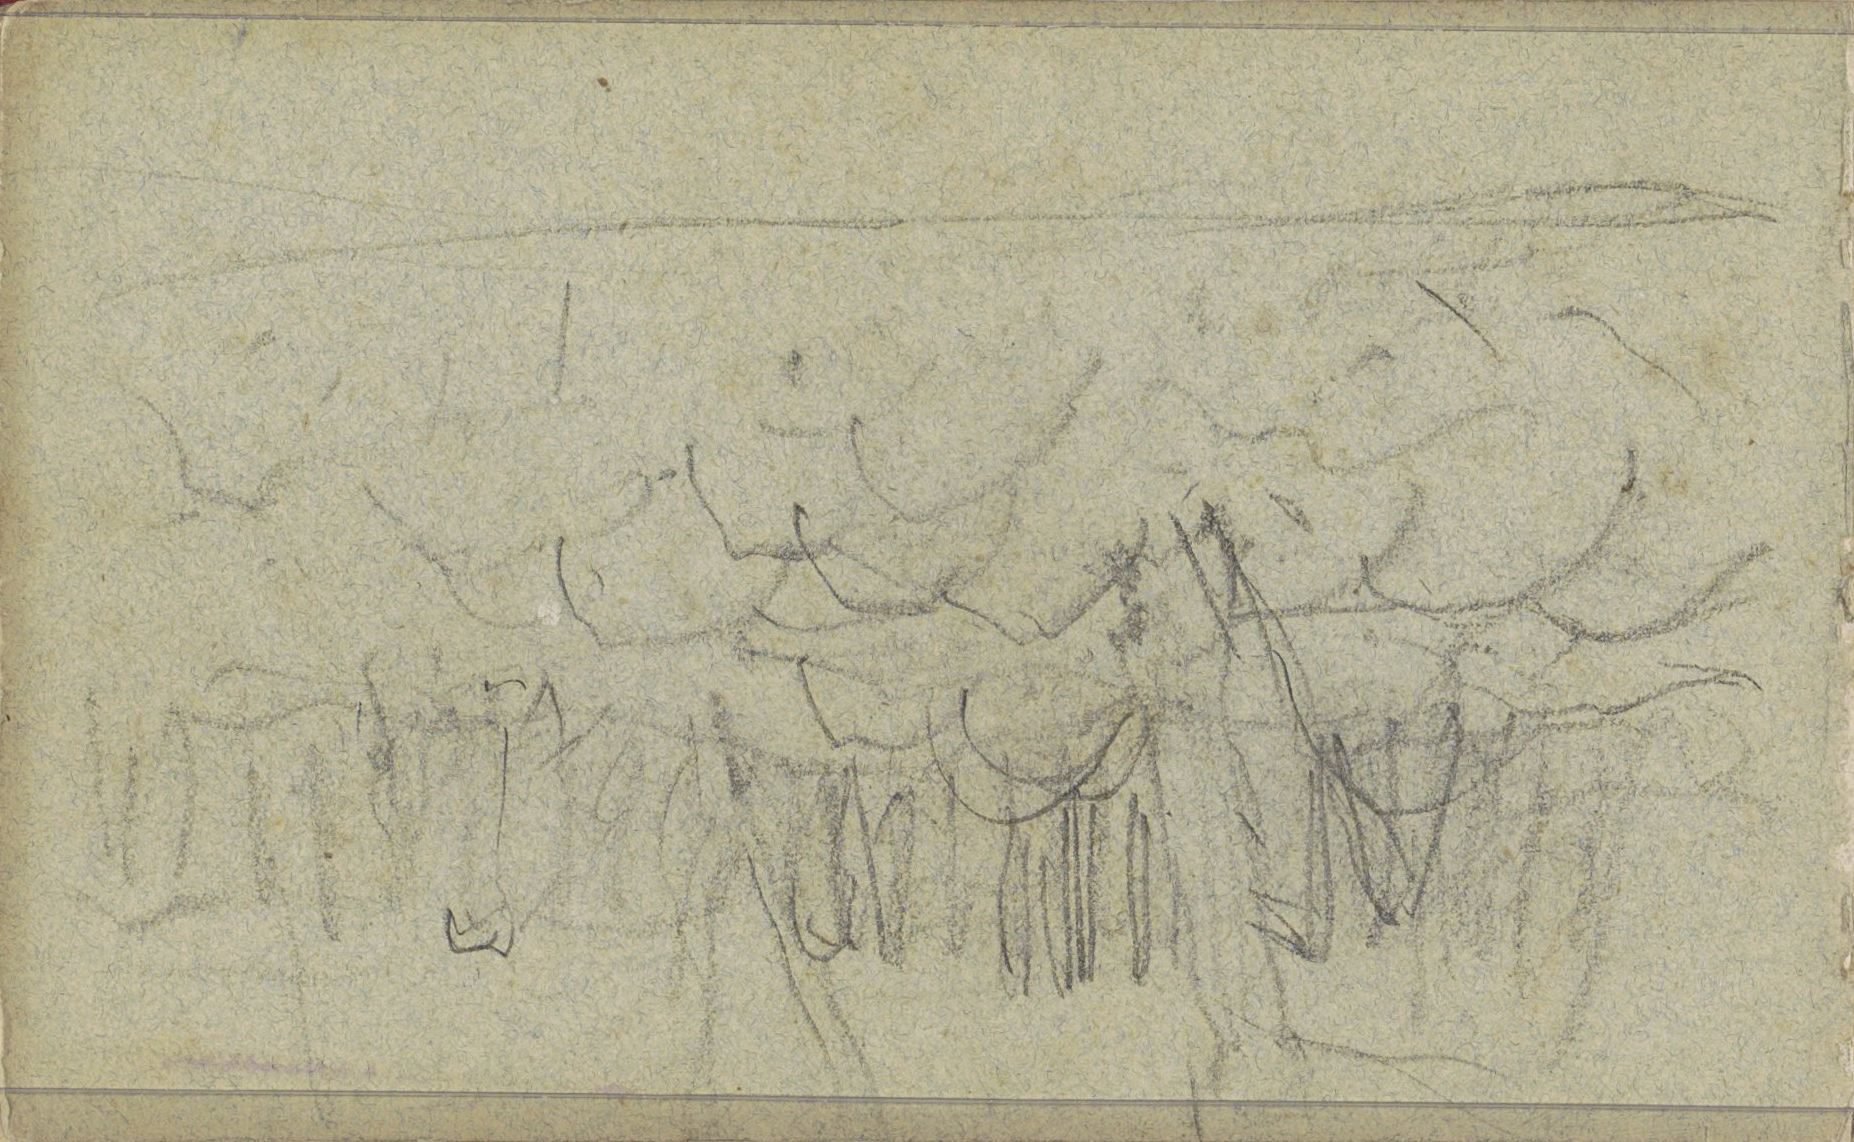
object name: sketchbook leaf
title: Schaapskudde bij een hek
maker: anton mauve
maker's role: draughtsman, painter, print maker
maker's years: 1838-1888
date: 1876-1888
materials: paper, pencil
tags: fence, wall, paling, sheep, herd, flock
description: Blad 32 verso uit een schetsboek met 34 bladen.